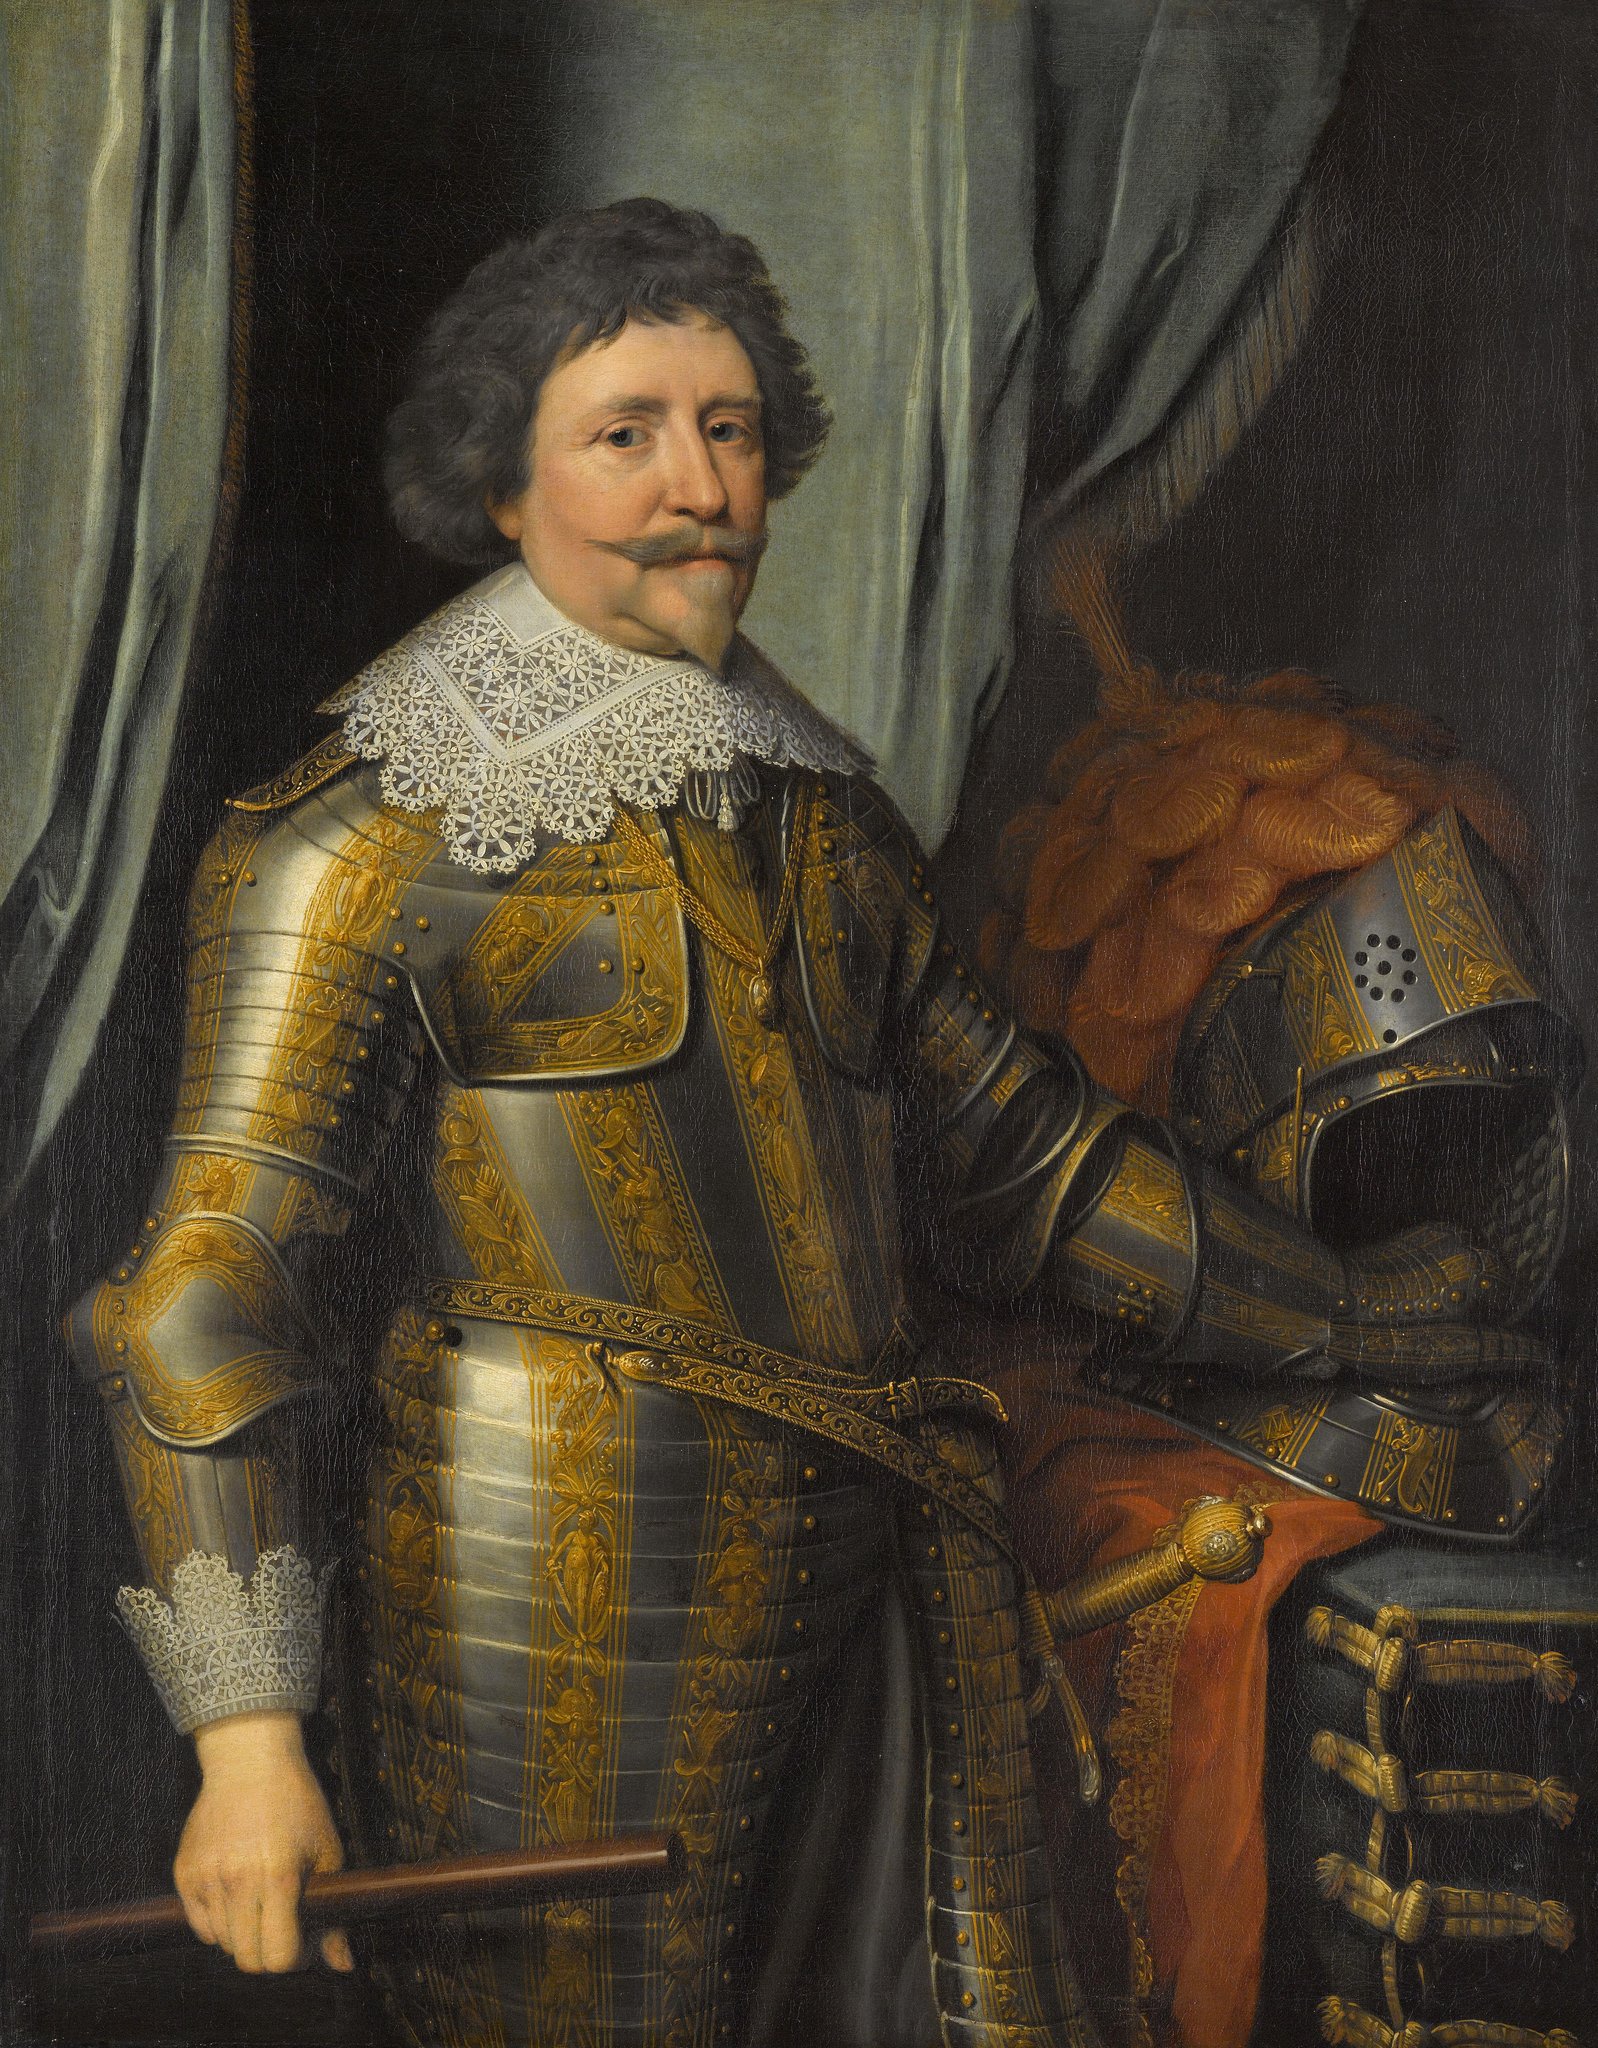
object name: painting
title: Frederick Henry, Prince of Orange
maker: michiel jansz van mierevelt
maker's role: draughtsman, painter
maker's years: 1567-1641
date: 1632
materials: canvas, oil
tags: delft, frederick henry (prince of orange), armour, prince, historical persons, baton of general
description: Prince Frederick Henry posed like a true commander for his court painter, Michiel van Mierevelt. Various copies of the likeness were subsequently made in the painter’s workshop, including the one on view here. This copy was commissioned by the Admiralty (navy) in Rotterdam, where it came to hang in the assembly hall, together with portraits of other members of the House of Orange.